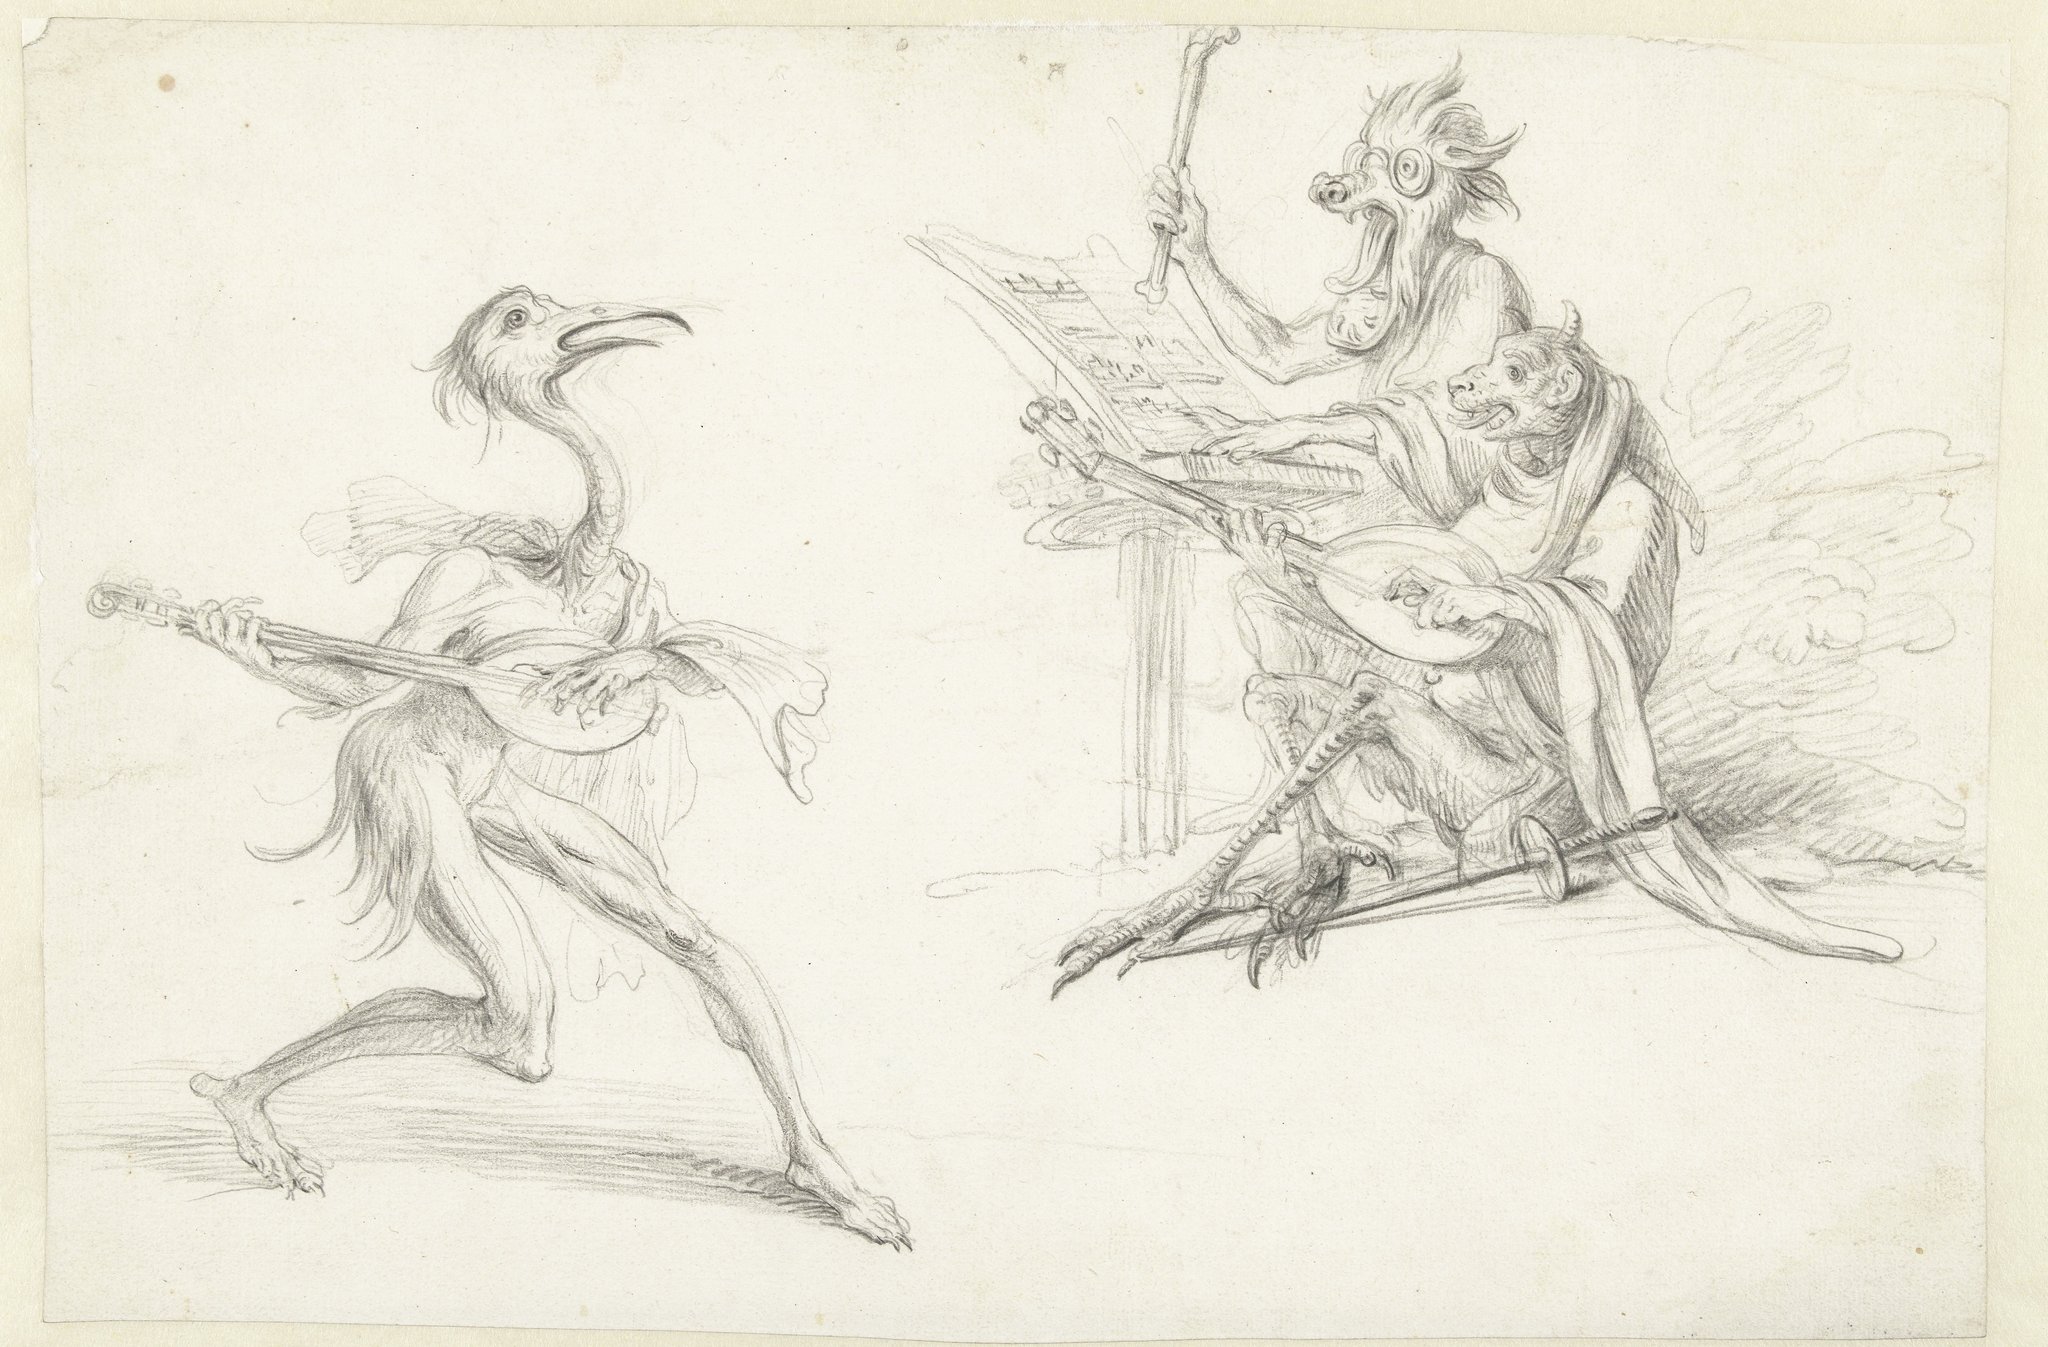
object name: drawing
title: Three Mythical Creatures Making Music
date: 1617-1681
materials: chalk, paper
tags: monsters of mixed human and animal shape; 'mostri' (ripa), lute, and special forms of lute, e.g.: theorbo, conductor ~ music, more than one musician with instrument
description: Drie muzikanten: links een dansende luitspeler met een vogelkop, rechts een zittende luitspeler en een duivelse dirigent, die met een bot de maat slaat.